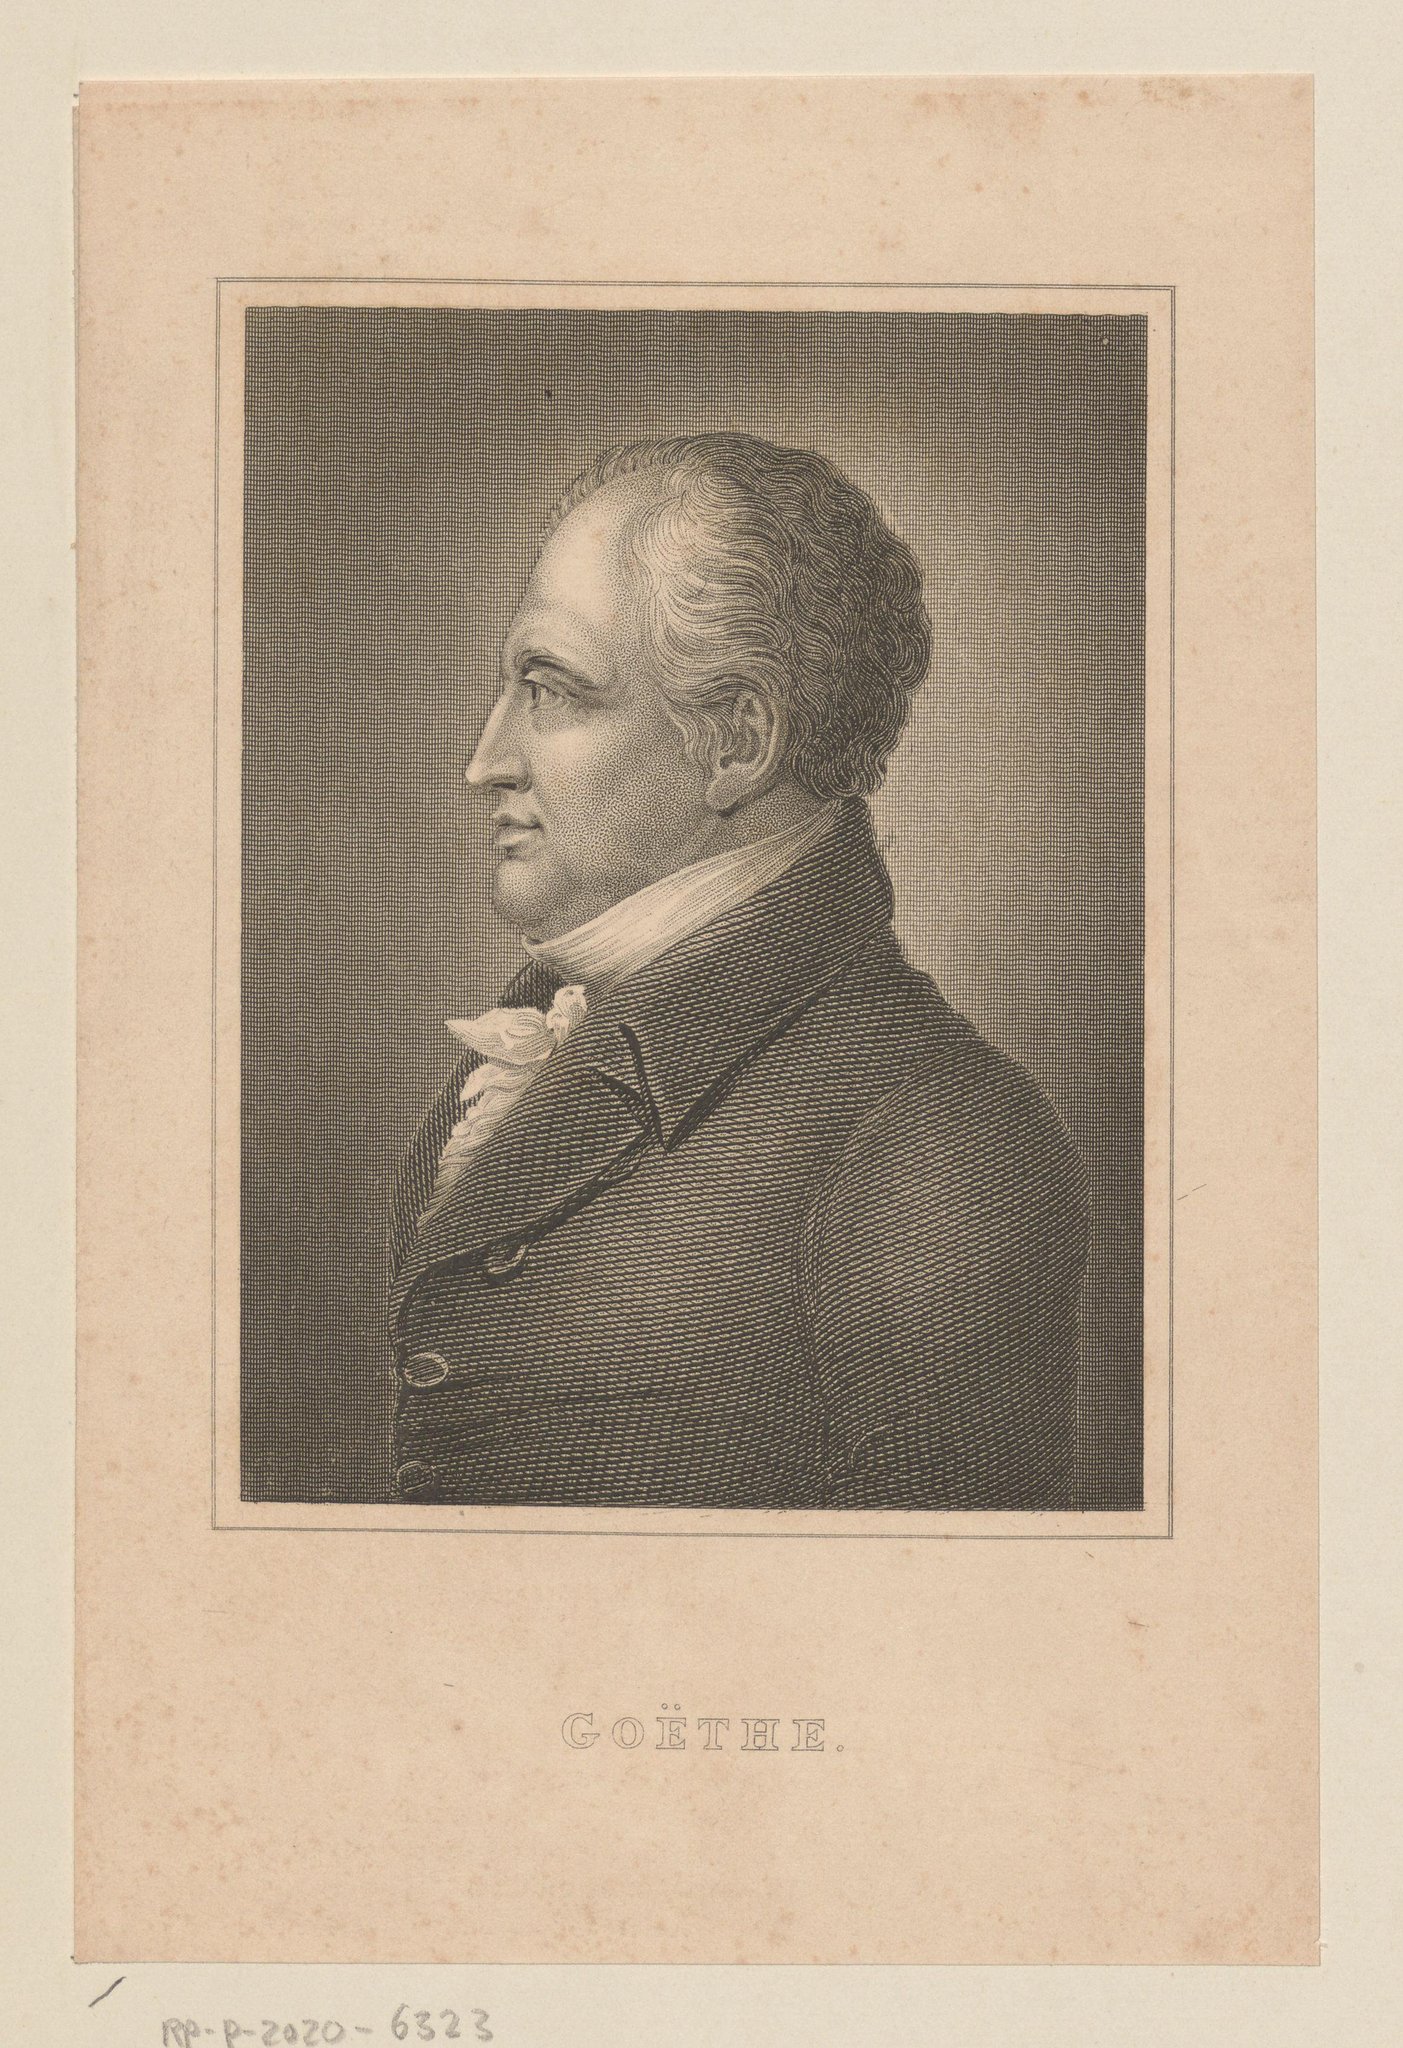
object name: print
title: Portret van Johann Wolfgang von Goethe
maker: Anonymous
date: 1780-1880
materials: paper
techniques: engraving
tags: draughtsman, johann wolfgang von goethe, historical persons, portrait of a writer